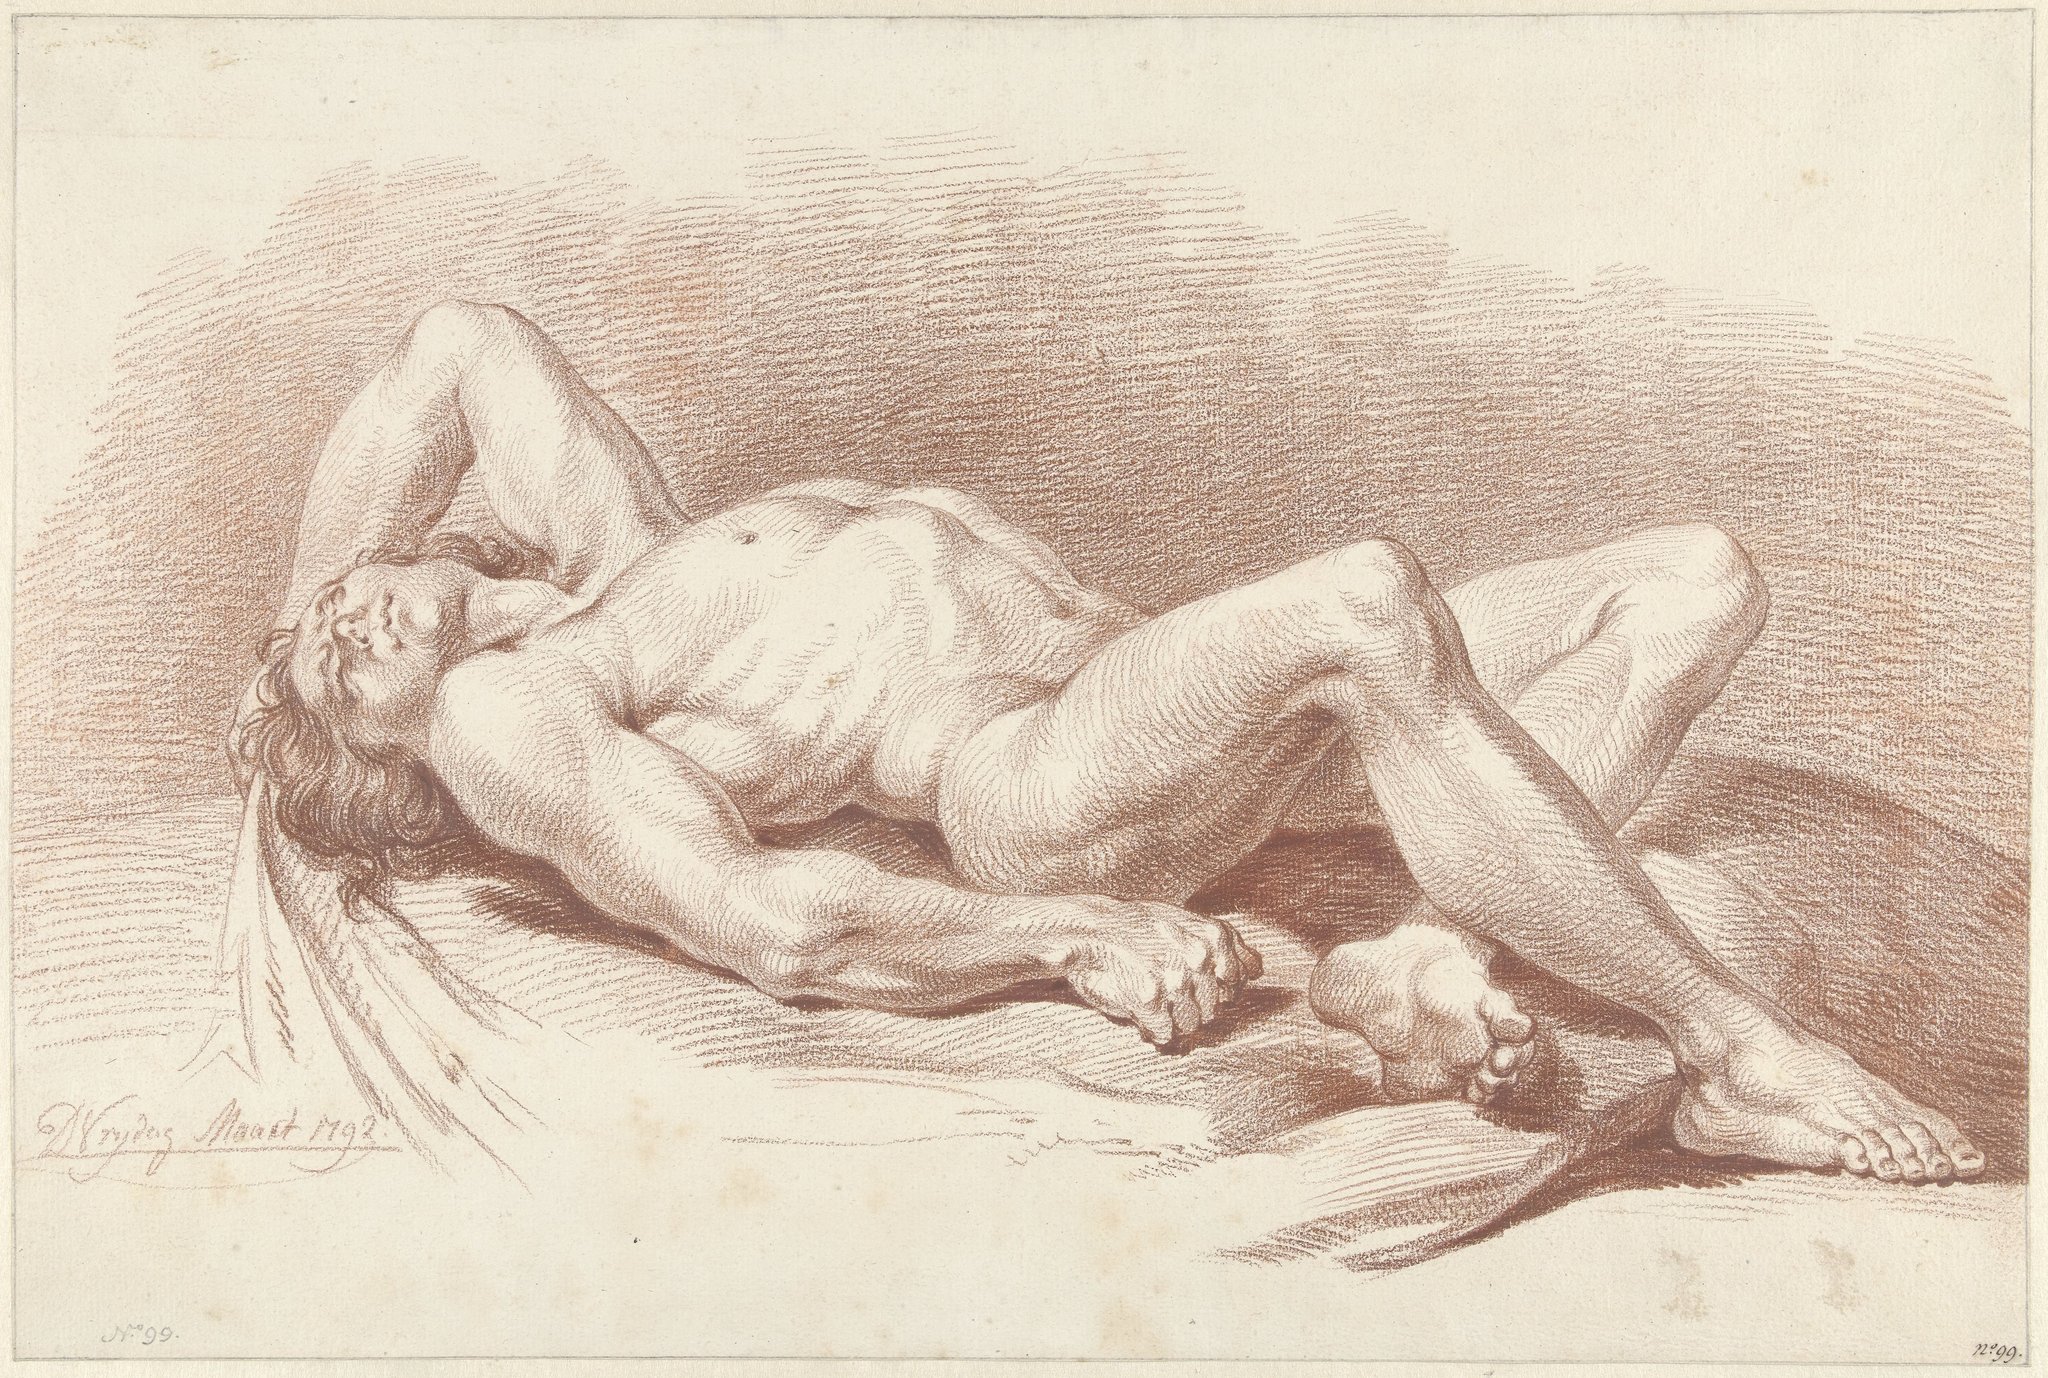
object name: drawing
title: Liggend mannelijk naakt, met arm achter het hoofd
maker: daniël vrijdag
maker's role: draughtsman, print maker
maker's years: 1765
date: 1703-1792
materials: chalk, paper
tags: lying figure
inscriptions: number: ‘No. 99’